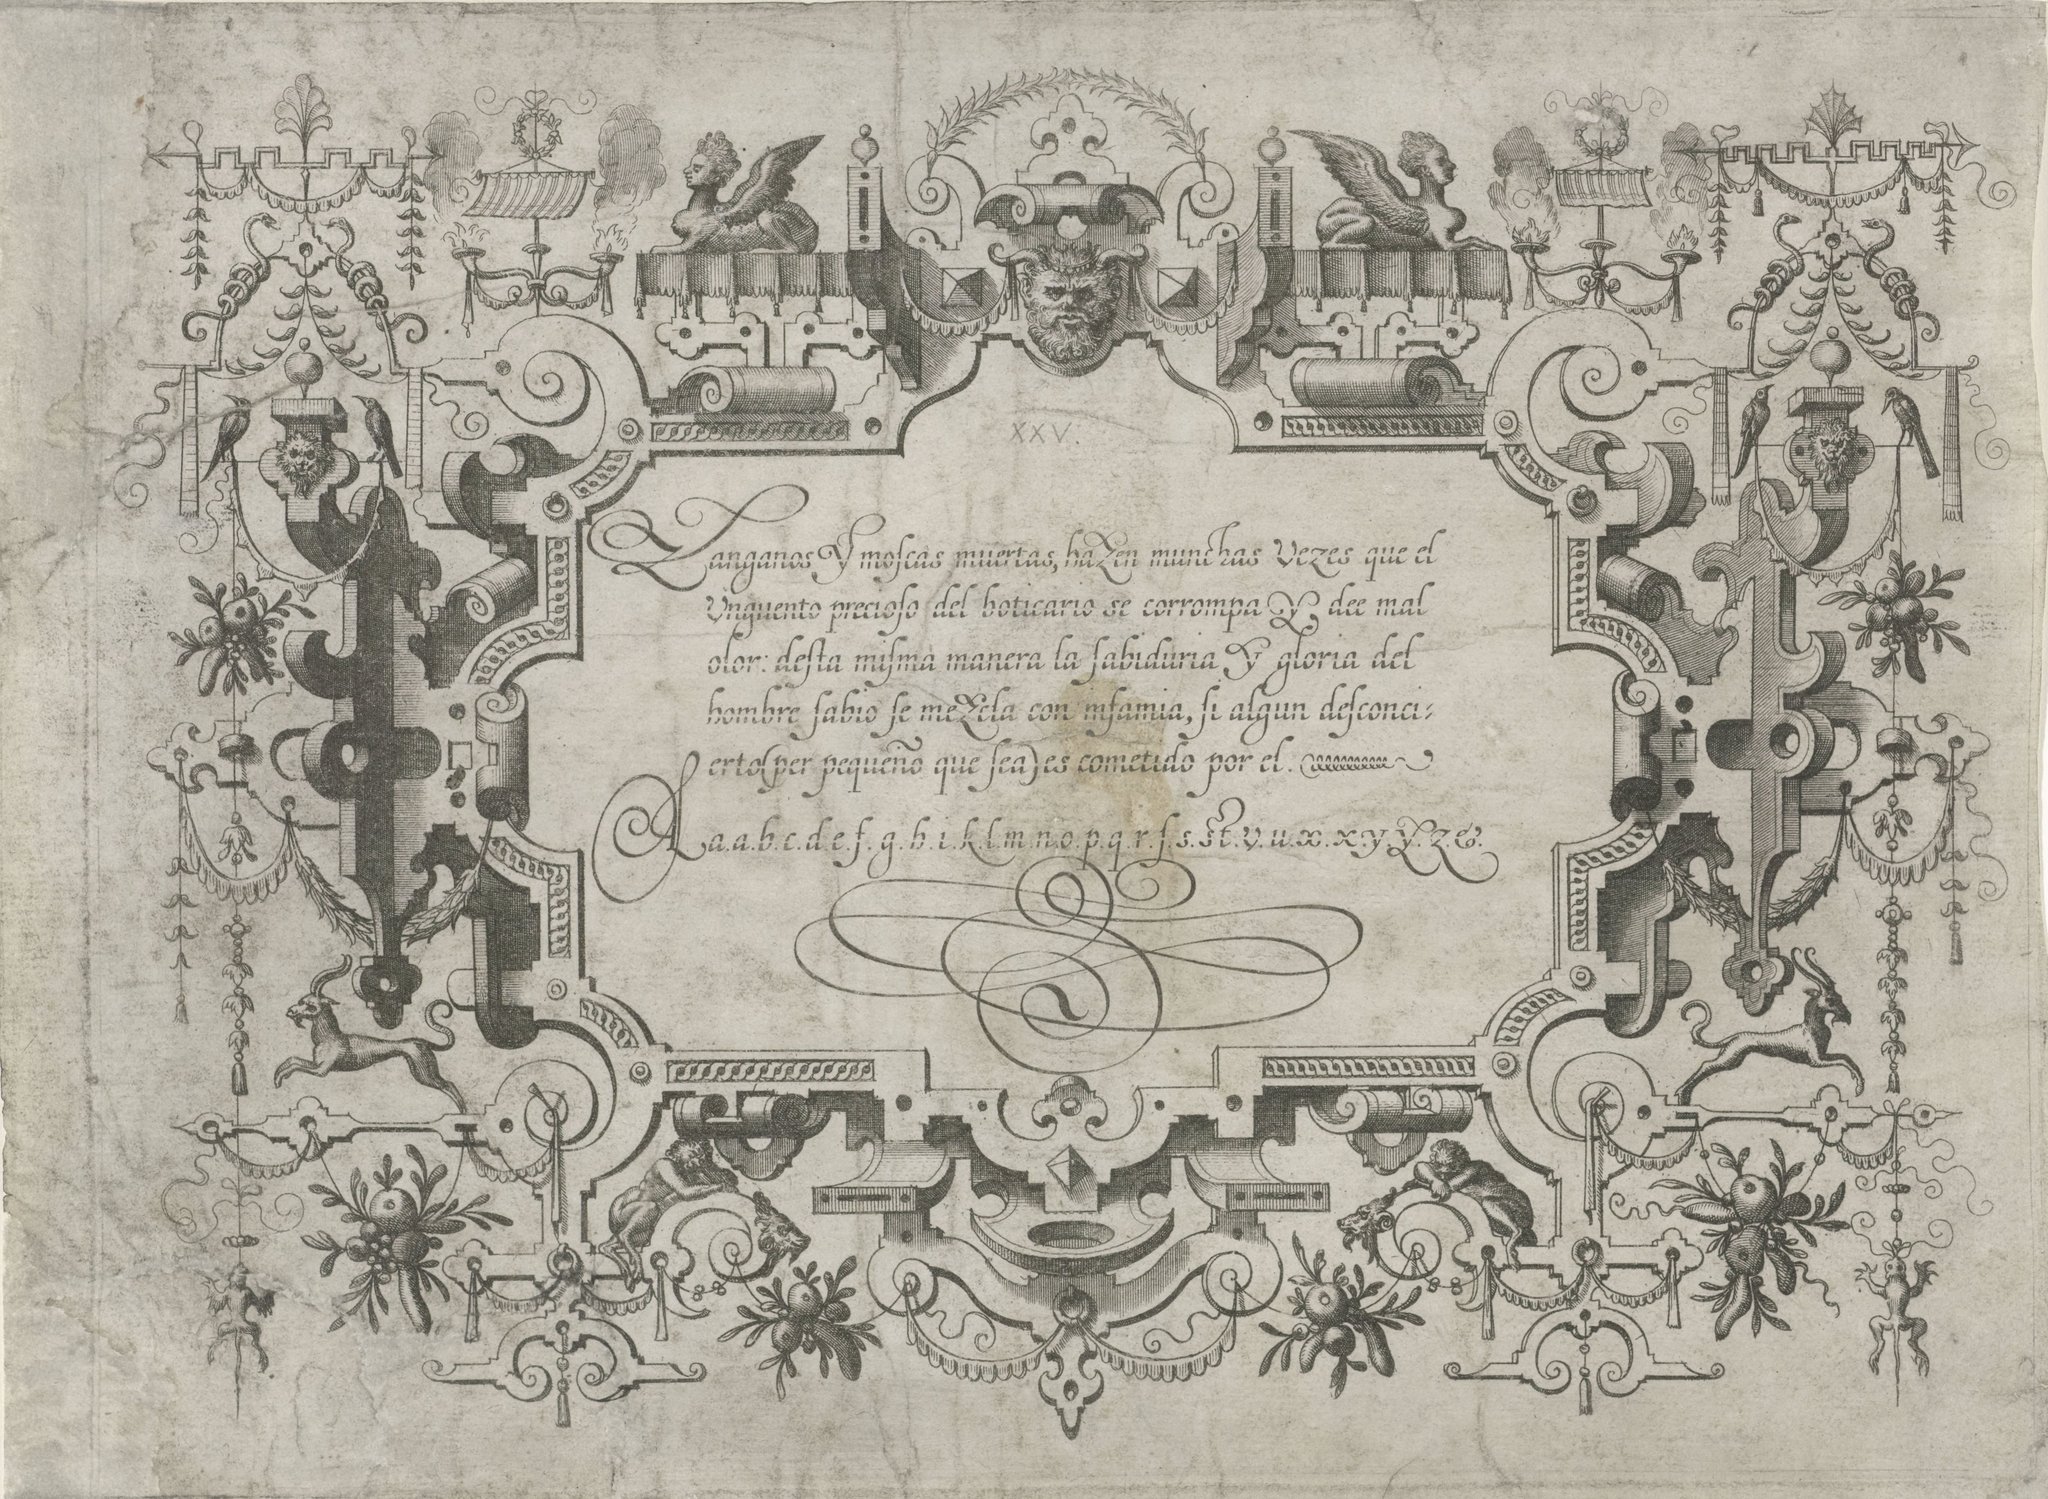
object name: print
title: Cartouche met kalligrafie, bovenaan hangt een mascaron met horens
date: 1569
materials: paper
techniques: engraving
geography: netherlands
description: Blad XXV. Cartouche met de tekst Zanganos y moscas muertas.... Onderaan liggen twee saters op voluten van beslagwerk te slapen. Uit serie van 21 genummerde cartouches met kalligrafie in een omlijsting van rol- en beslagwerk met grotesken, guirlandes en mascarons.